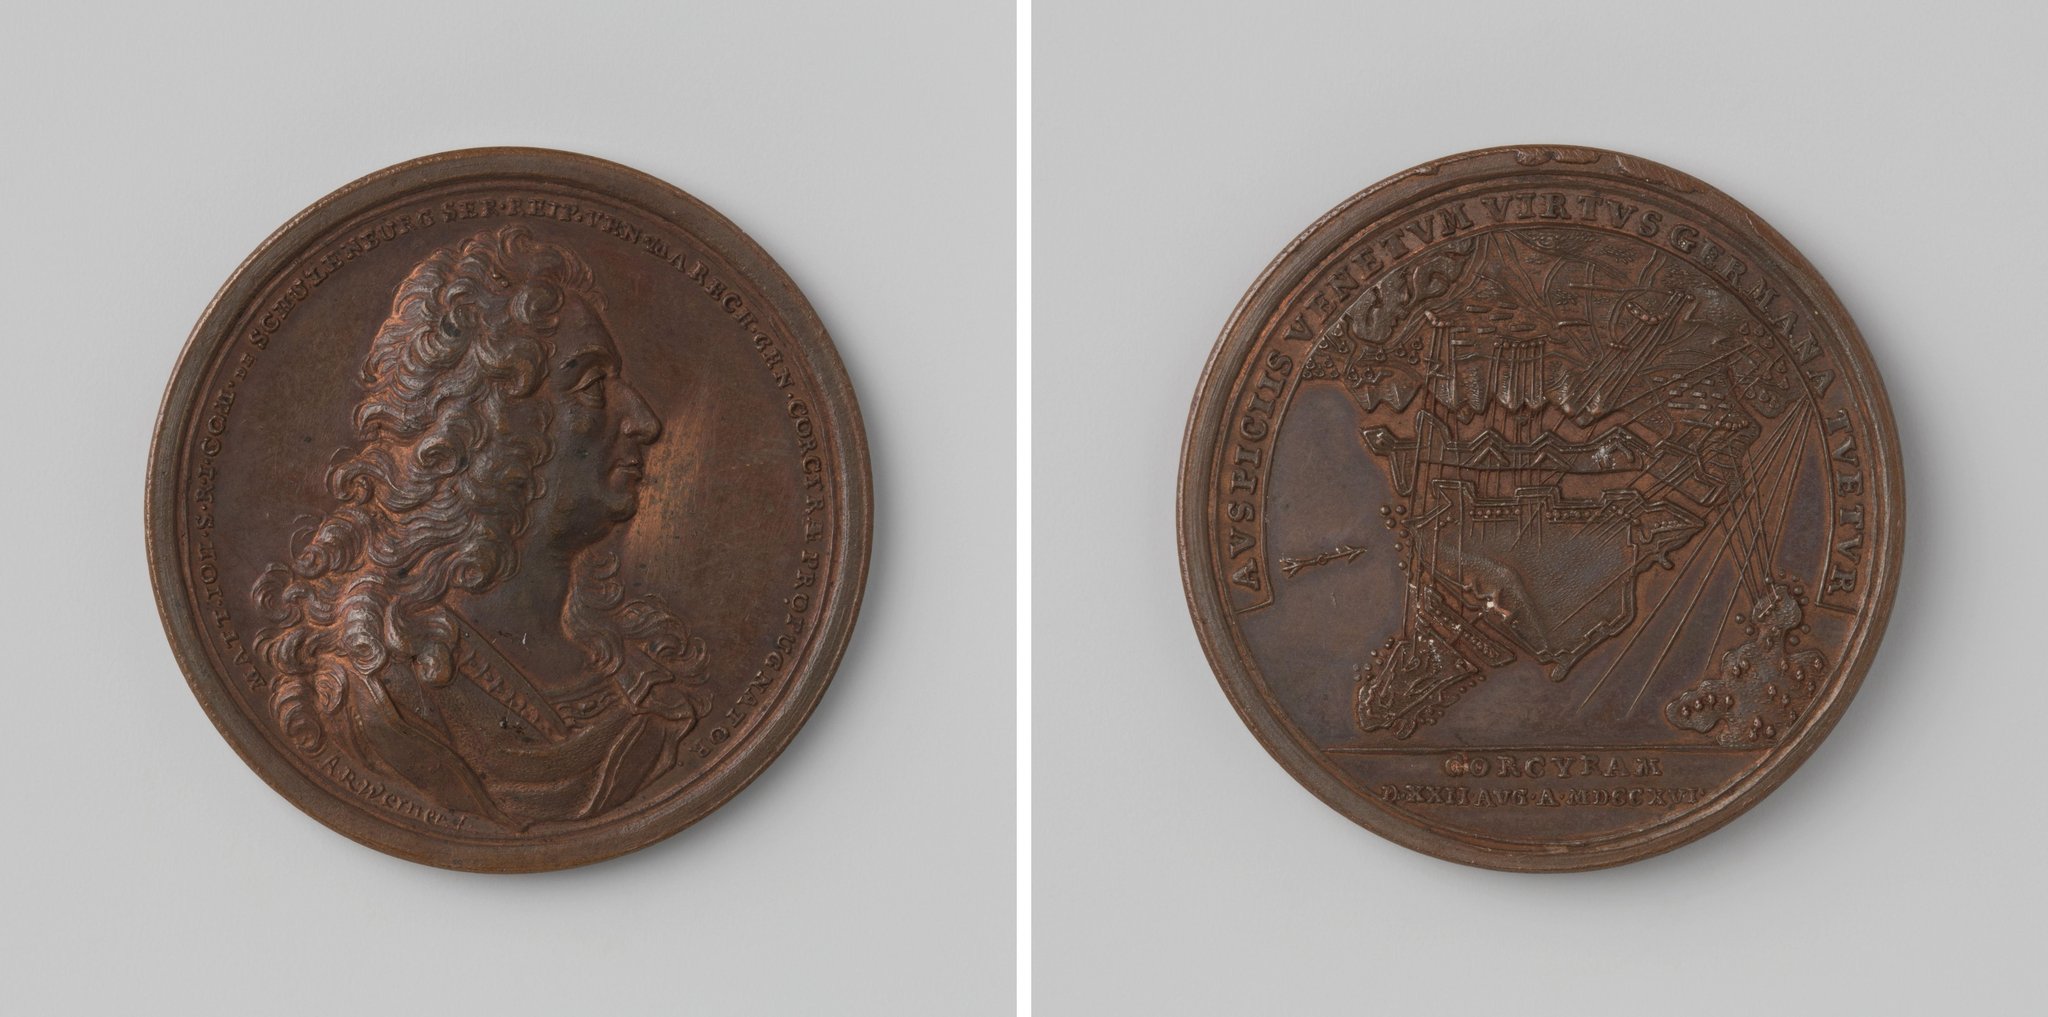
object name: history medal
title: Verdediging van Corcyra door Mattheus Johannes, graaf van Schulenburg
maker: adam rudolph werner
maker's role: medailleur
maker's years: 1722-1784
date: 1742-1784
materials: bronze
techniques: striking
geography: stuttgart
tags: emden, verona, militair, matthias johann von der schulenburg, griekenland, korfoe, oorlog tegen de turken (1716-1718), verdediging van corcyra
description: Bronzen penning. Voorzijde: borststuk man binnen omschrift. Keerzijde: plattegrond van Corcyra binnen omschrift; afsnede: opschrift